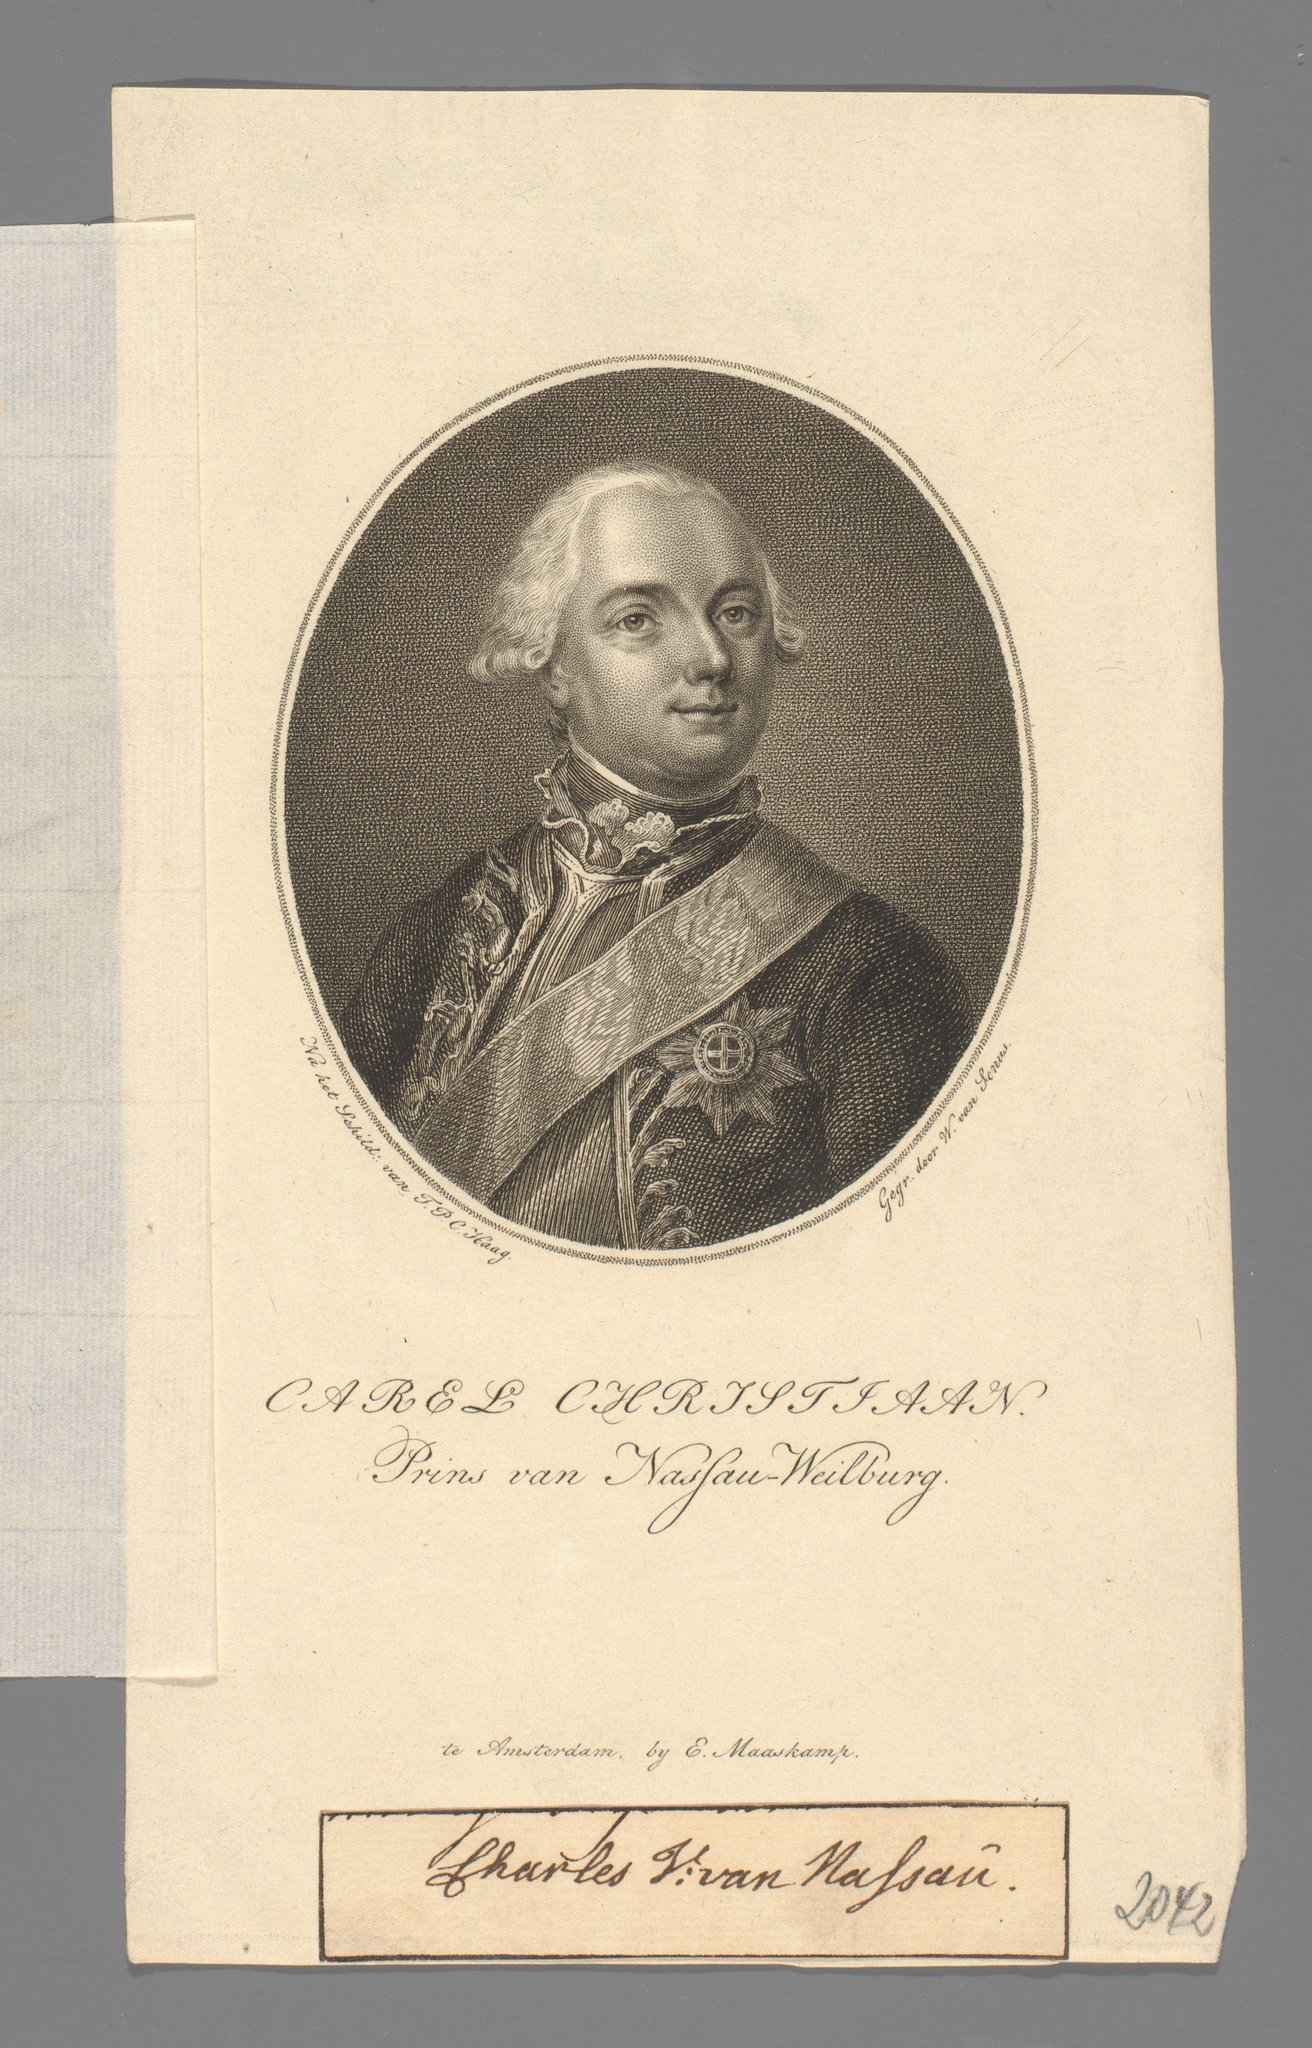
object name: document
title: Handtekening van Karel Christiaan van Nassau-Weilburg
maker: karel christiaan vorst van nassau-weilburg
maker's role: generaal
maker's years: 1735-1788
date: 1750-1788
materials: ink, paper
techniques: writing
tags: karel christiaan vorst van nassau-weilburg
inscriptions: inscription: ‘Charles V:van Nassau.’